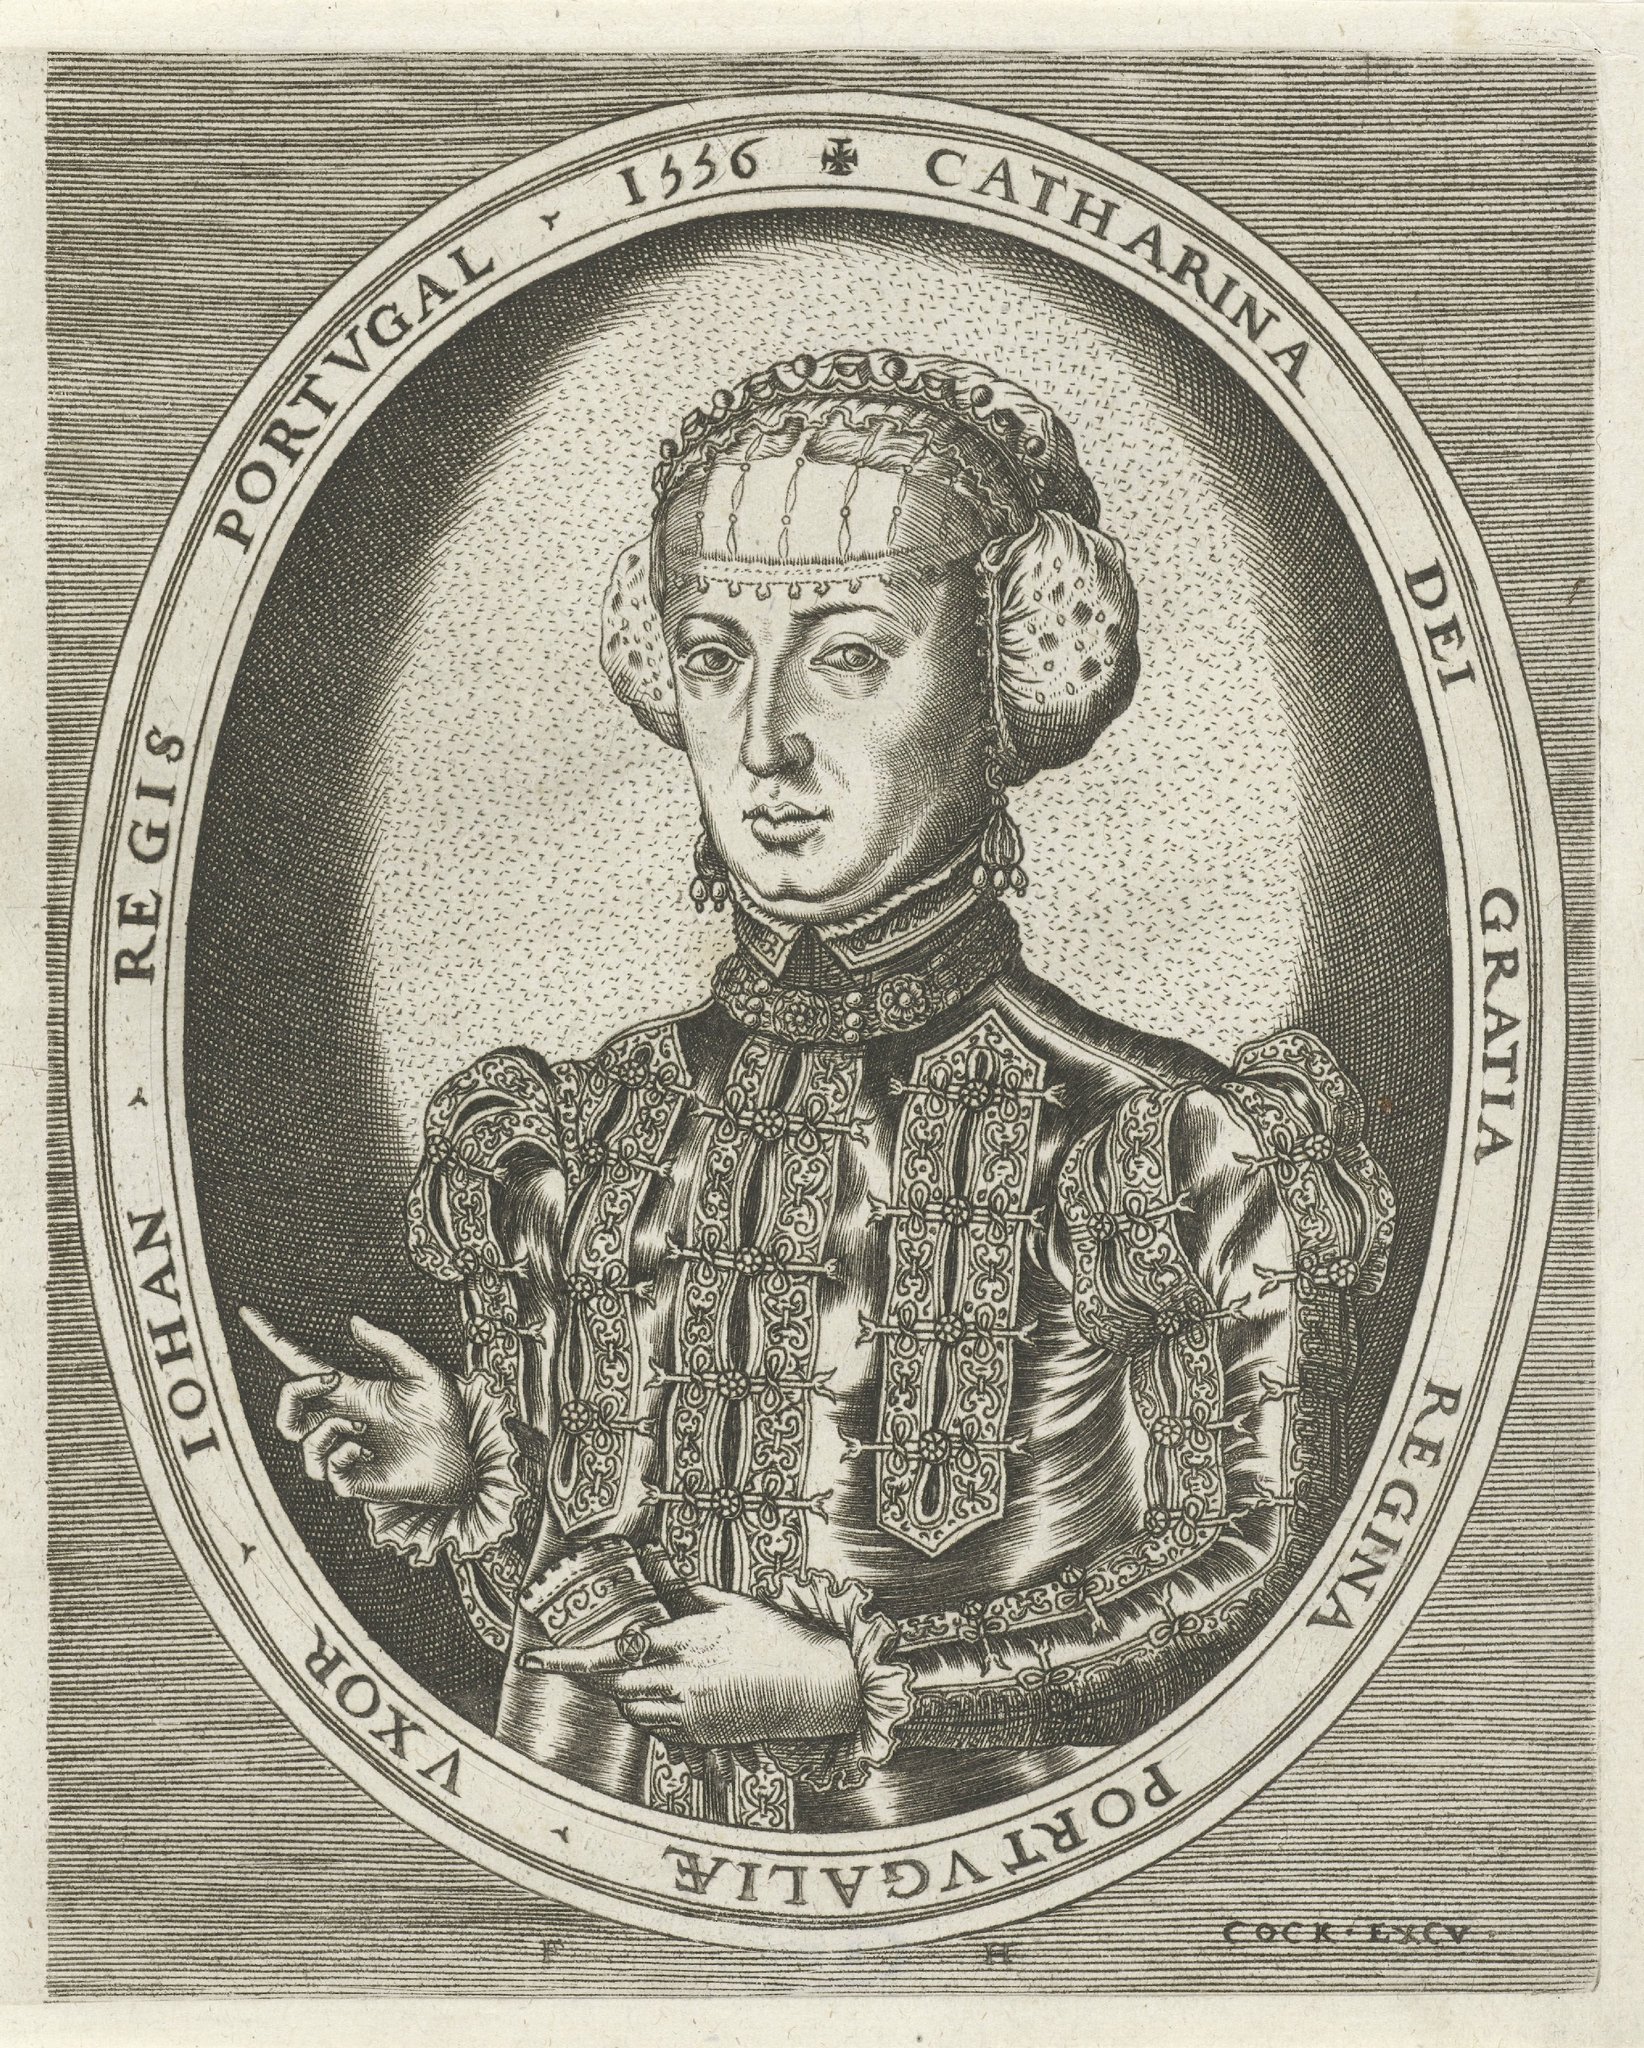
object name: print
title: Portret van Catharina van Habsburg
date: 1546-1562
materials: paper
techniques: engraving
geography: antwerp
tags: catharina van habsburg (koningin van portugal)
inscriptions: collector's mark: Lugt 2228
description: Portret van Catharina van Habsburg, koningin van Portugal, ten halven lijve naar links in een ovale lijst met randschrift in het Latijn.